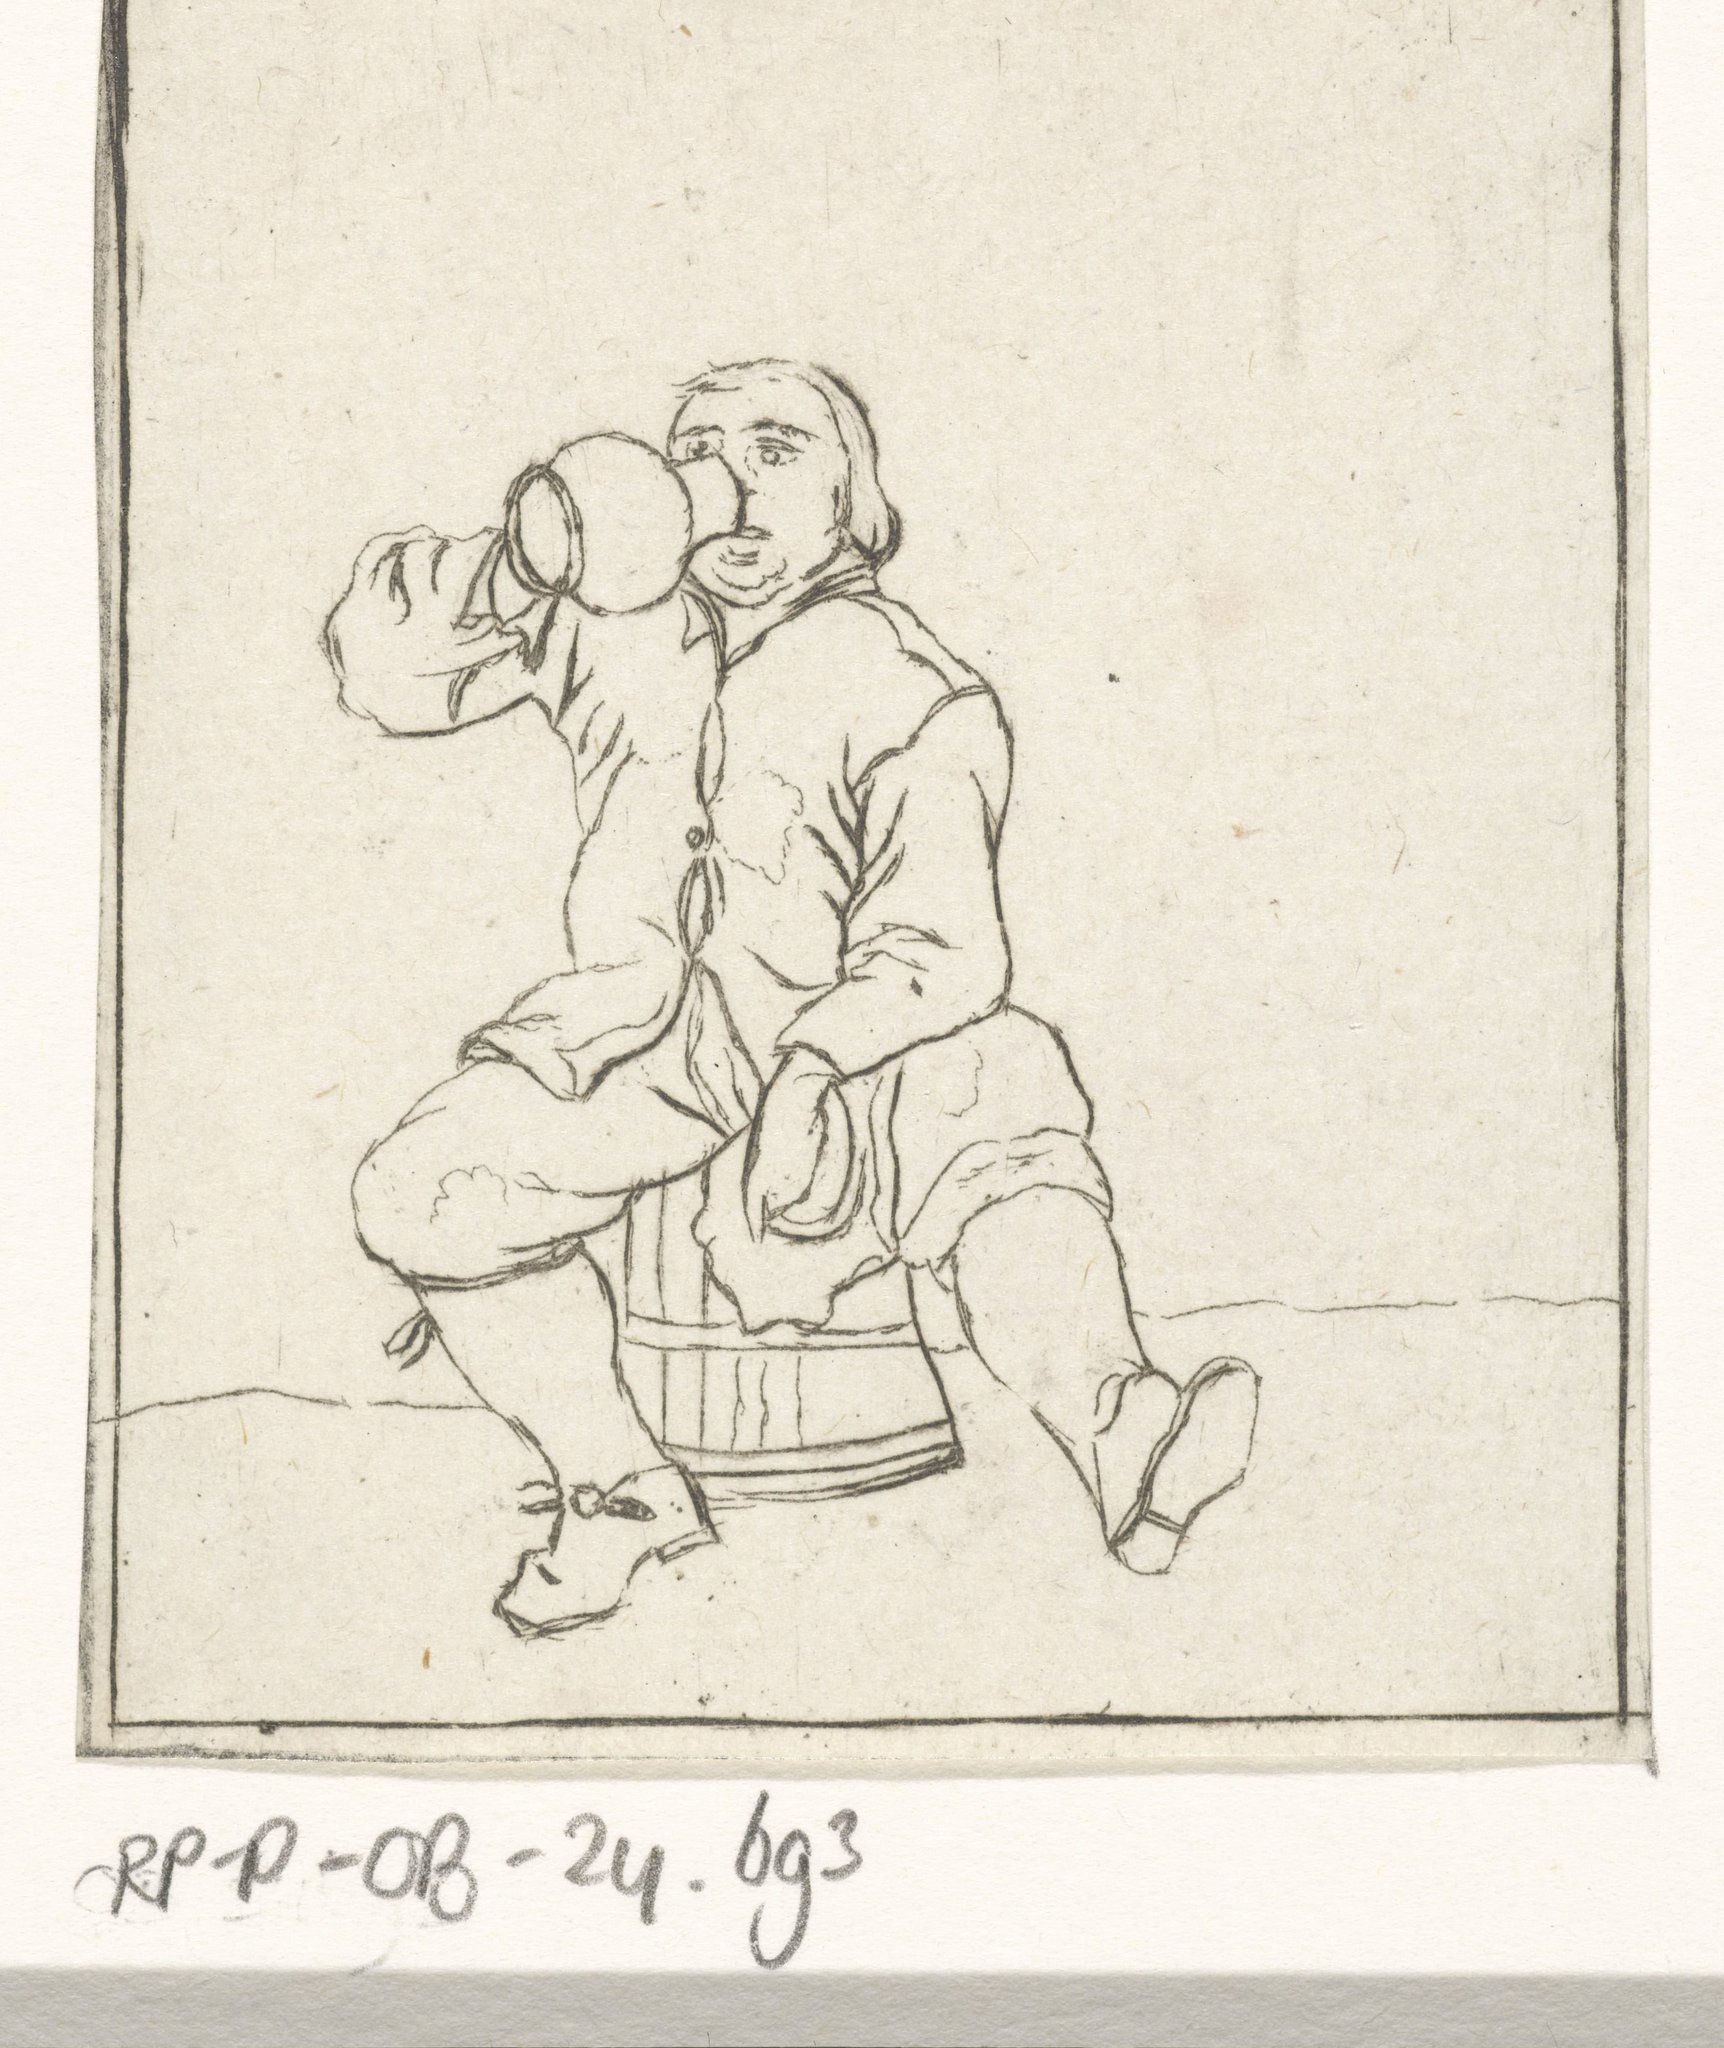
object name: print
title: Drinkende man zittend op een ton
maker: cornelis ploos van amstel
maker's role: draughtsman, print maker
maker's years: 1726-1798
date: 1736-1798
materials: paper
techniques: etching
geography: amsterdam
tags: jar, jug (used as drinking-vessel), drinking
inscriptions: collector's mark: Lugt 240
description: Een man zet een kruik aan zijn mond, terwijl hij op een ton zit.